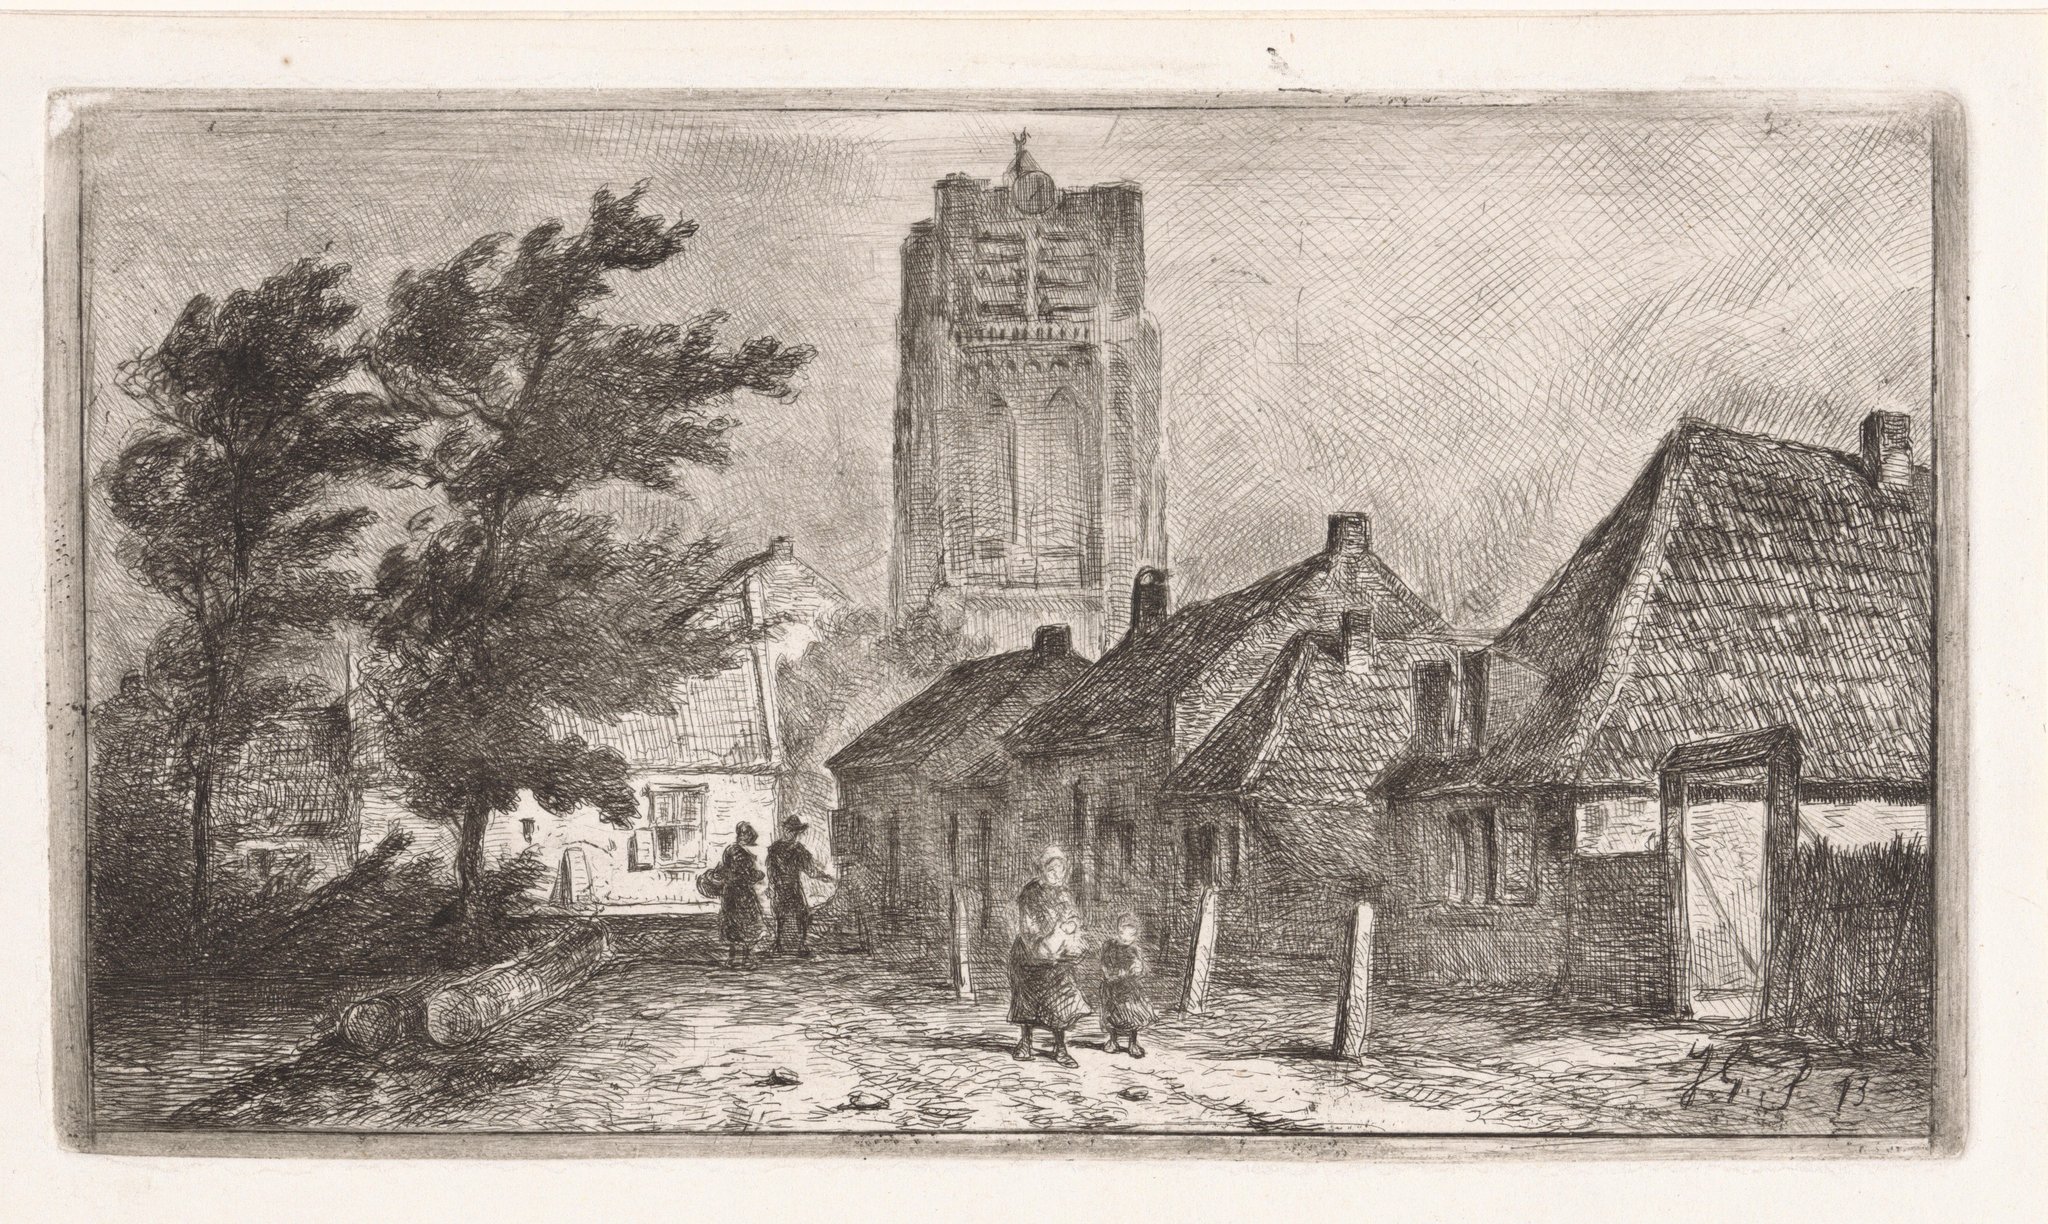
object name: print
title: Dorpsgezicht met kerktoren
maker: jan gerard smits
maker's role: draughtsman, print maker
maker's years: 1823-1910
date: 1873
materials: paper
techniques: drypoint, etching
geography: the hague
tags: public road in village, wijk bij duurstede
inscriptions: collector's mark: Lugt 2228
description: Dorpsstraat met wandelende mensen. Op de achtergrond een forse kerktoren. Mogelijk Wijk bij Duurstede?